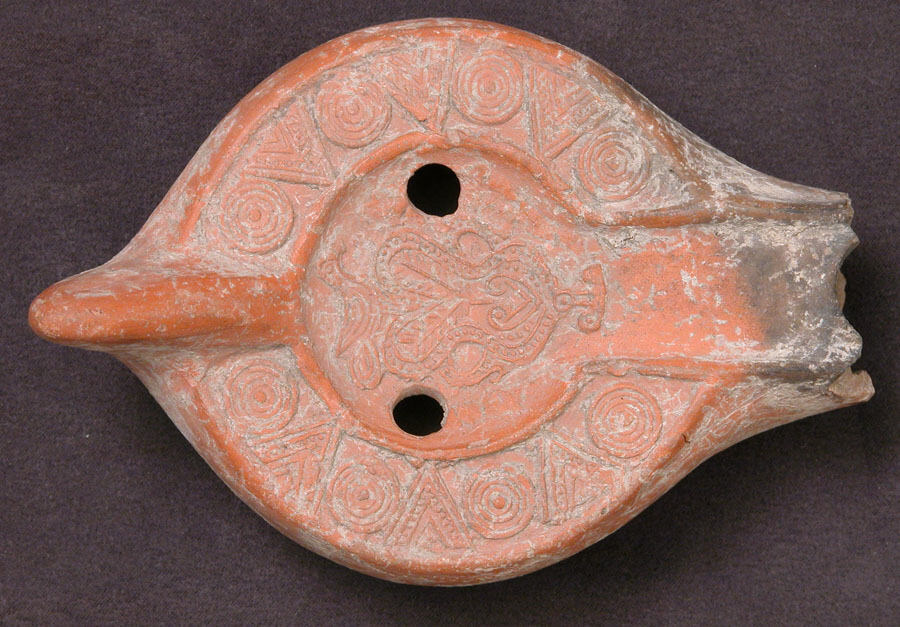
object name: lamp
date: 401-600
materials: earthenware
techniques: molding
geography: egypt